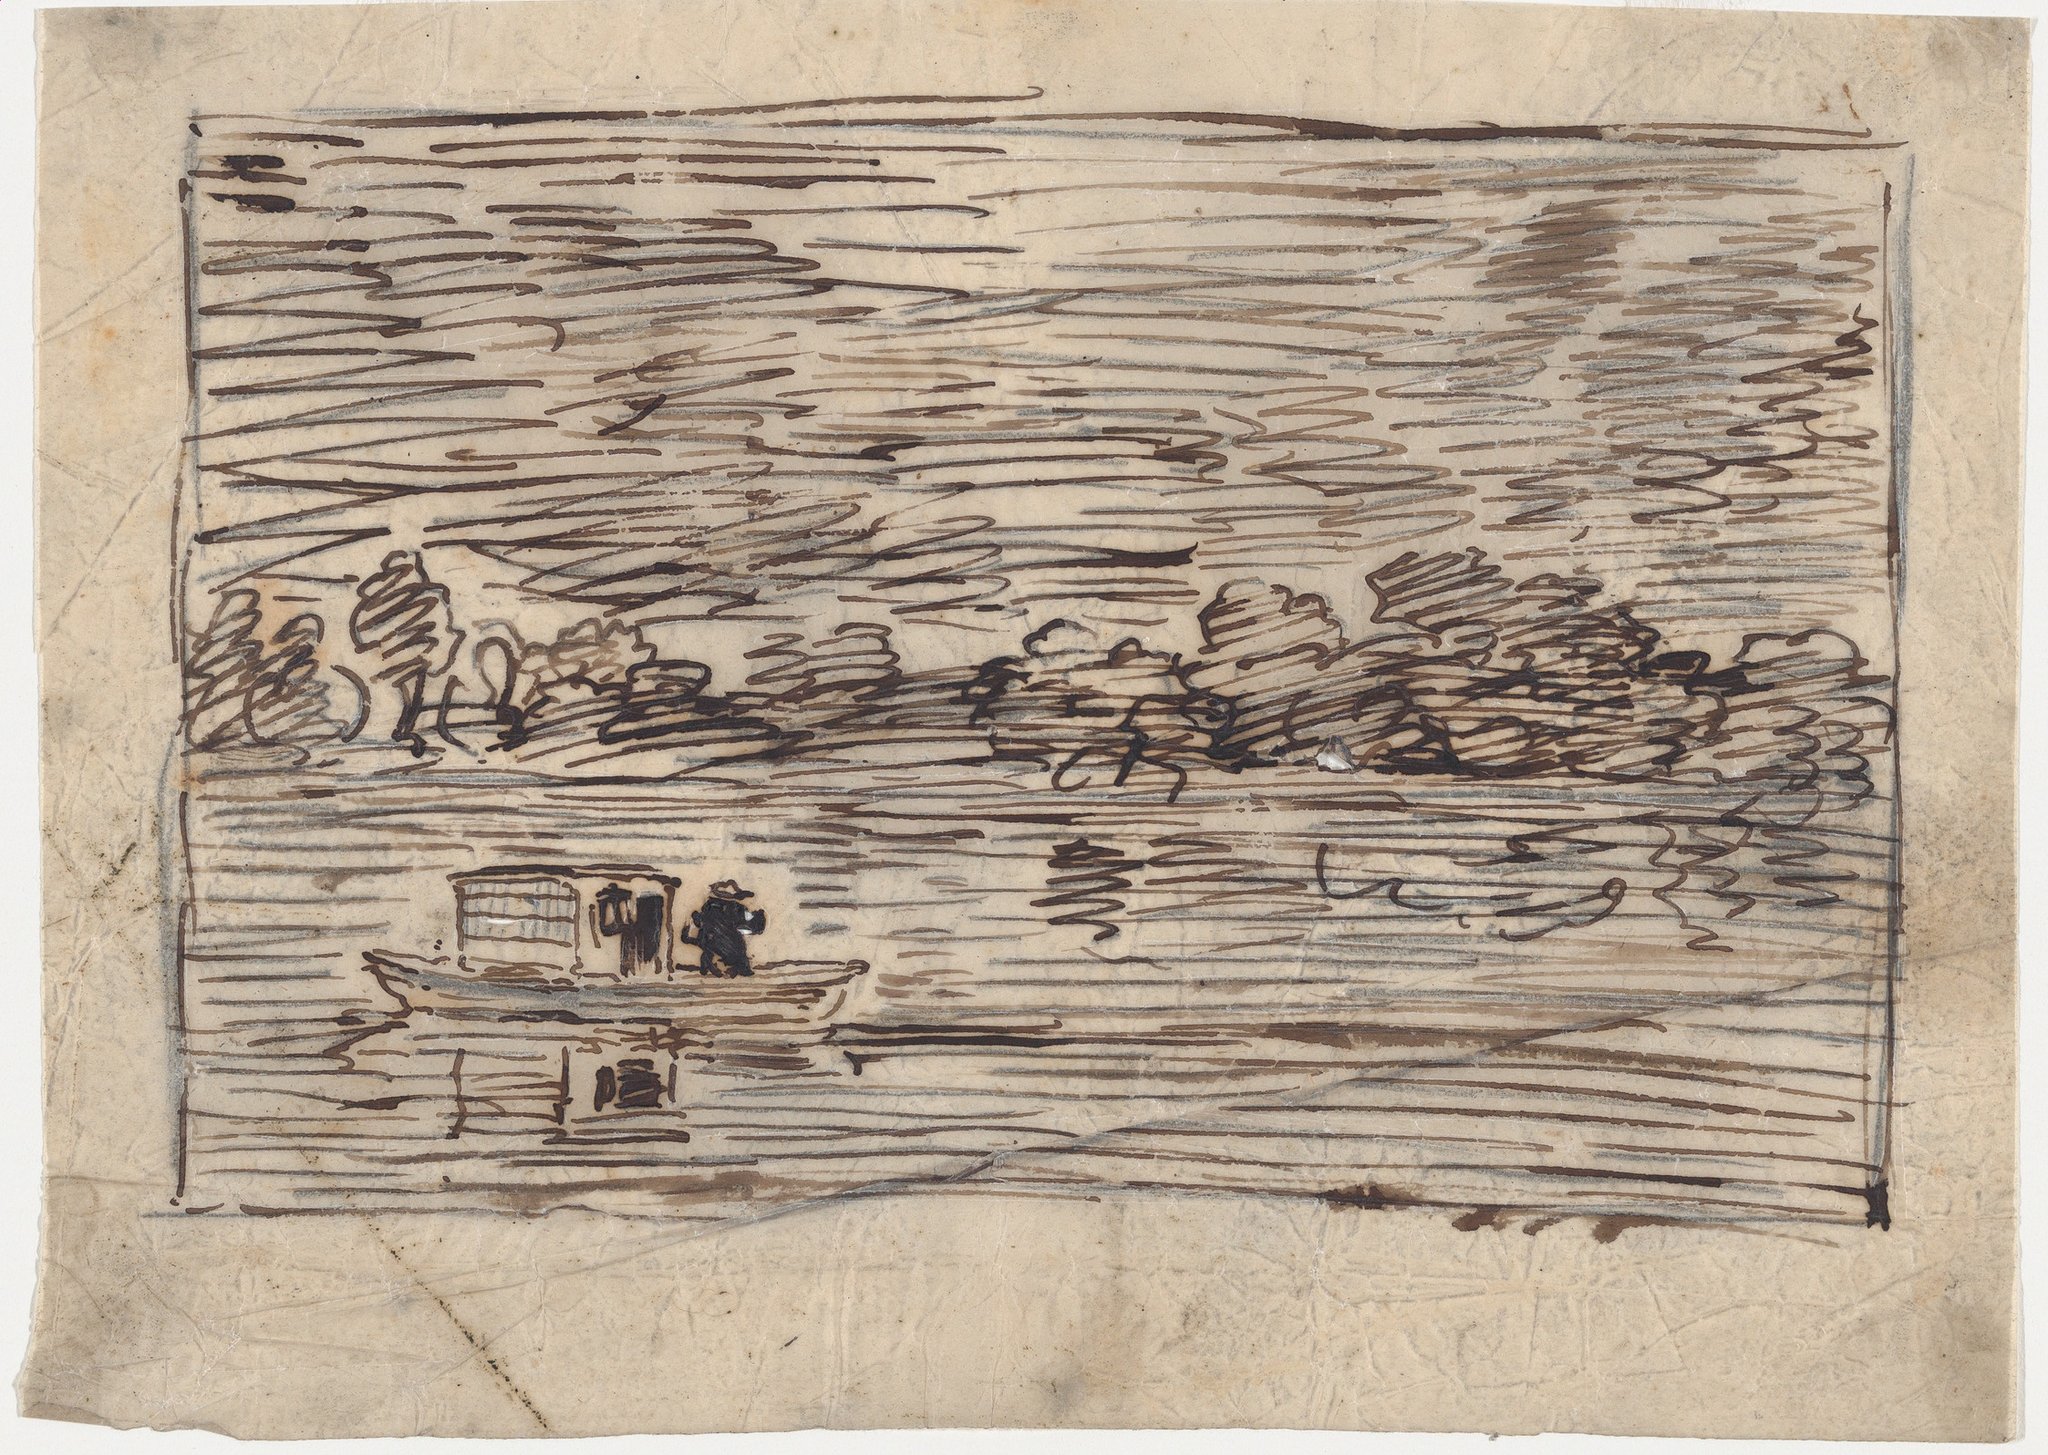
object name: drawing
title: Night Voyage or Net Fishing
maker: charles-françois daubigny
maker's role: artist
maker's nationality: french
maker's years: 1817-1878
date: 1862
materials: graphite, ink, paper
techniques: pen